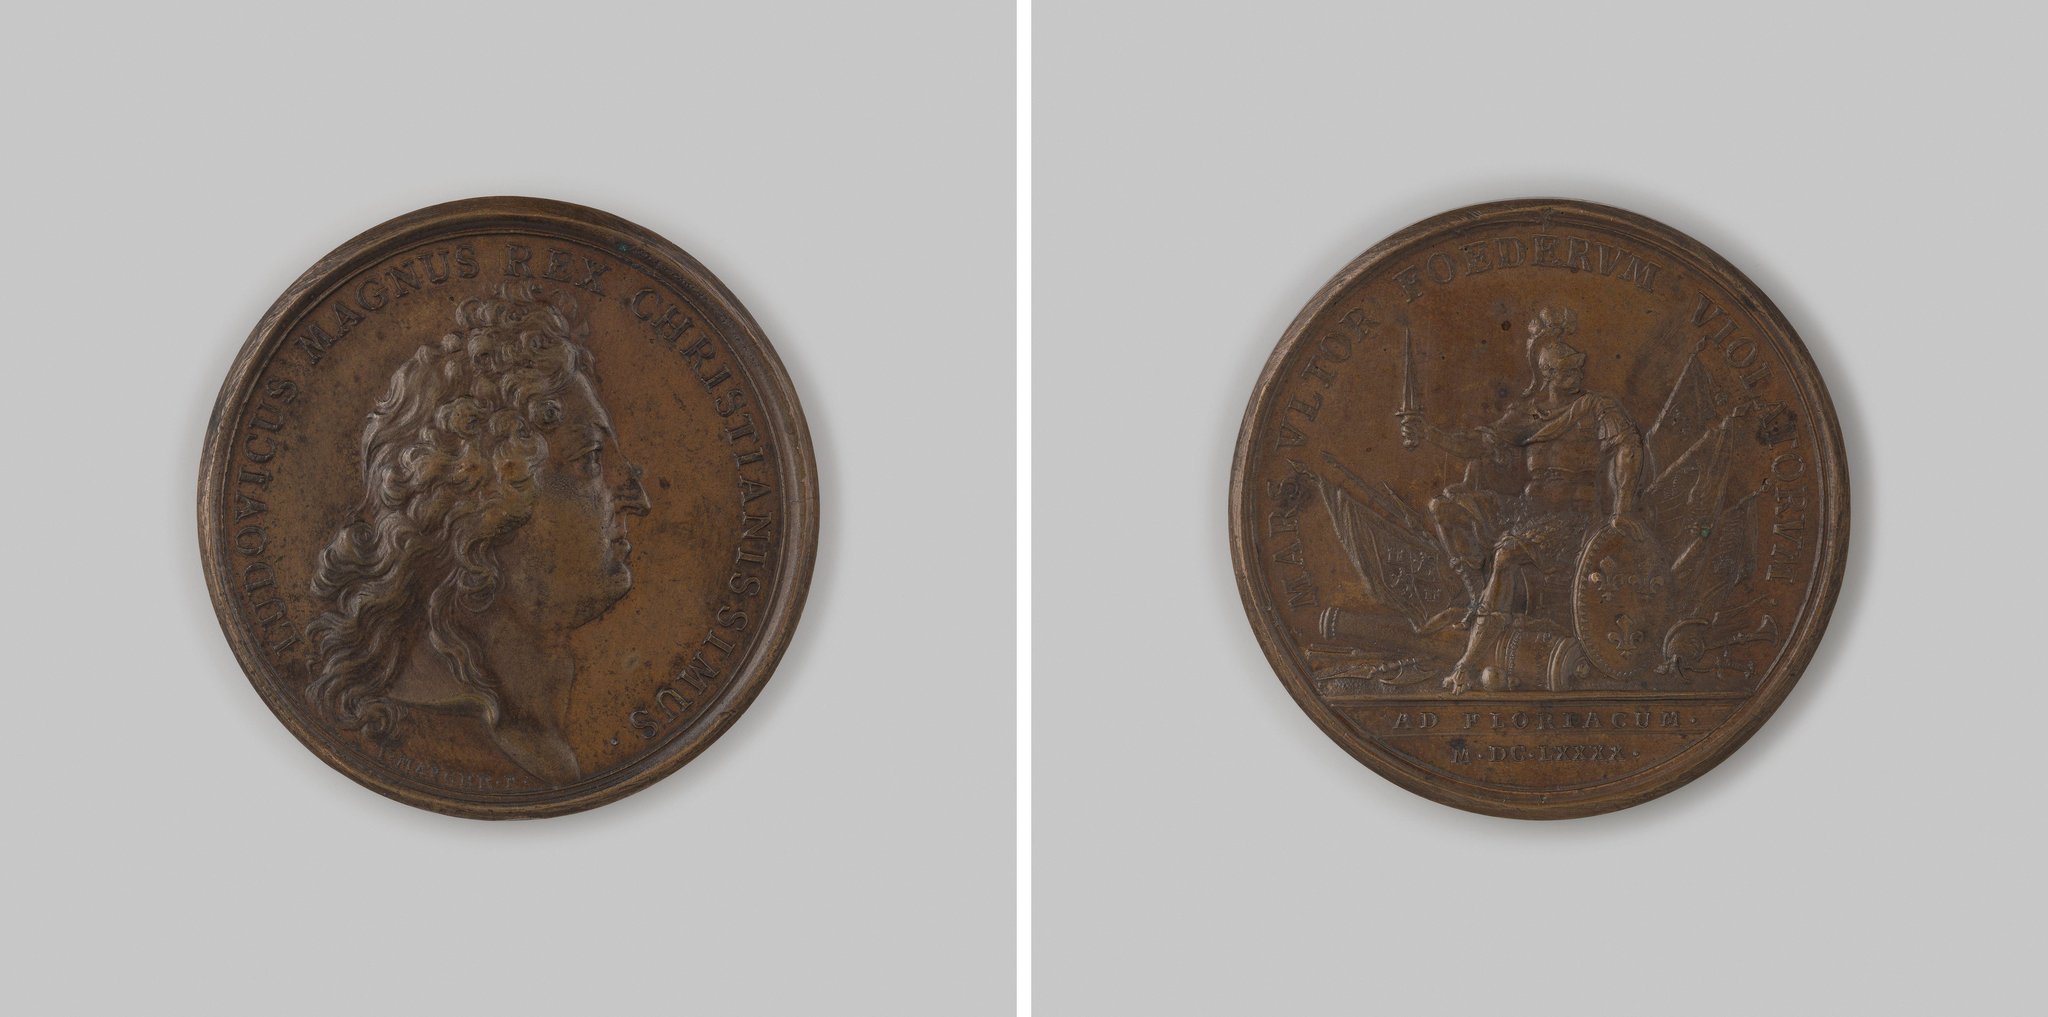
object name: history medal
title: Slag bij Fleury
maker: jean mauger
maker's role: medailleur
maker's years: 1648-1722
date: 1699-1703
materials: bronze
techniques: striking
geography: paris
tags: lodewijk xiv (koning van frankrijk), henegouwen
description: Bronzen penning. Voorzijde: borststuk man binnen omschrift. Keerzijde: Mars met zwaard en wapenschild zittend op wapentuig binnen omschrift; afsnede: opschrift